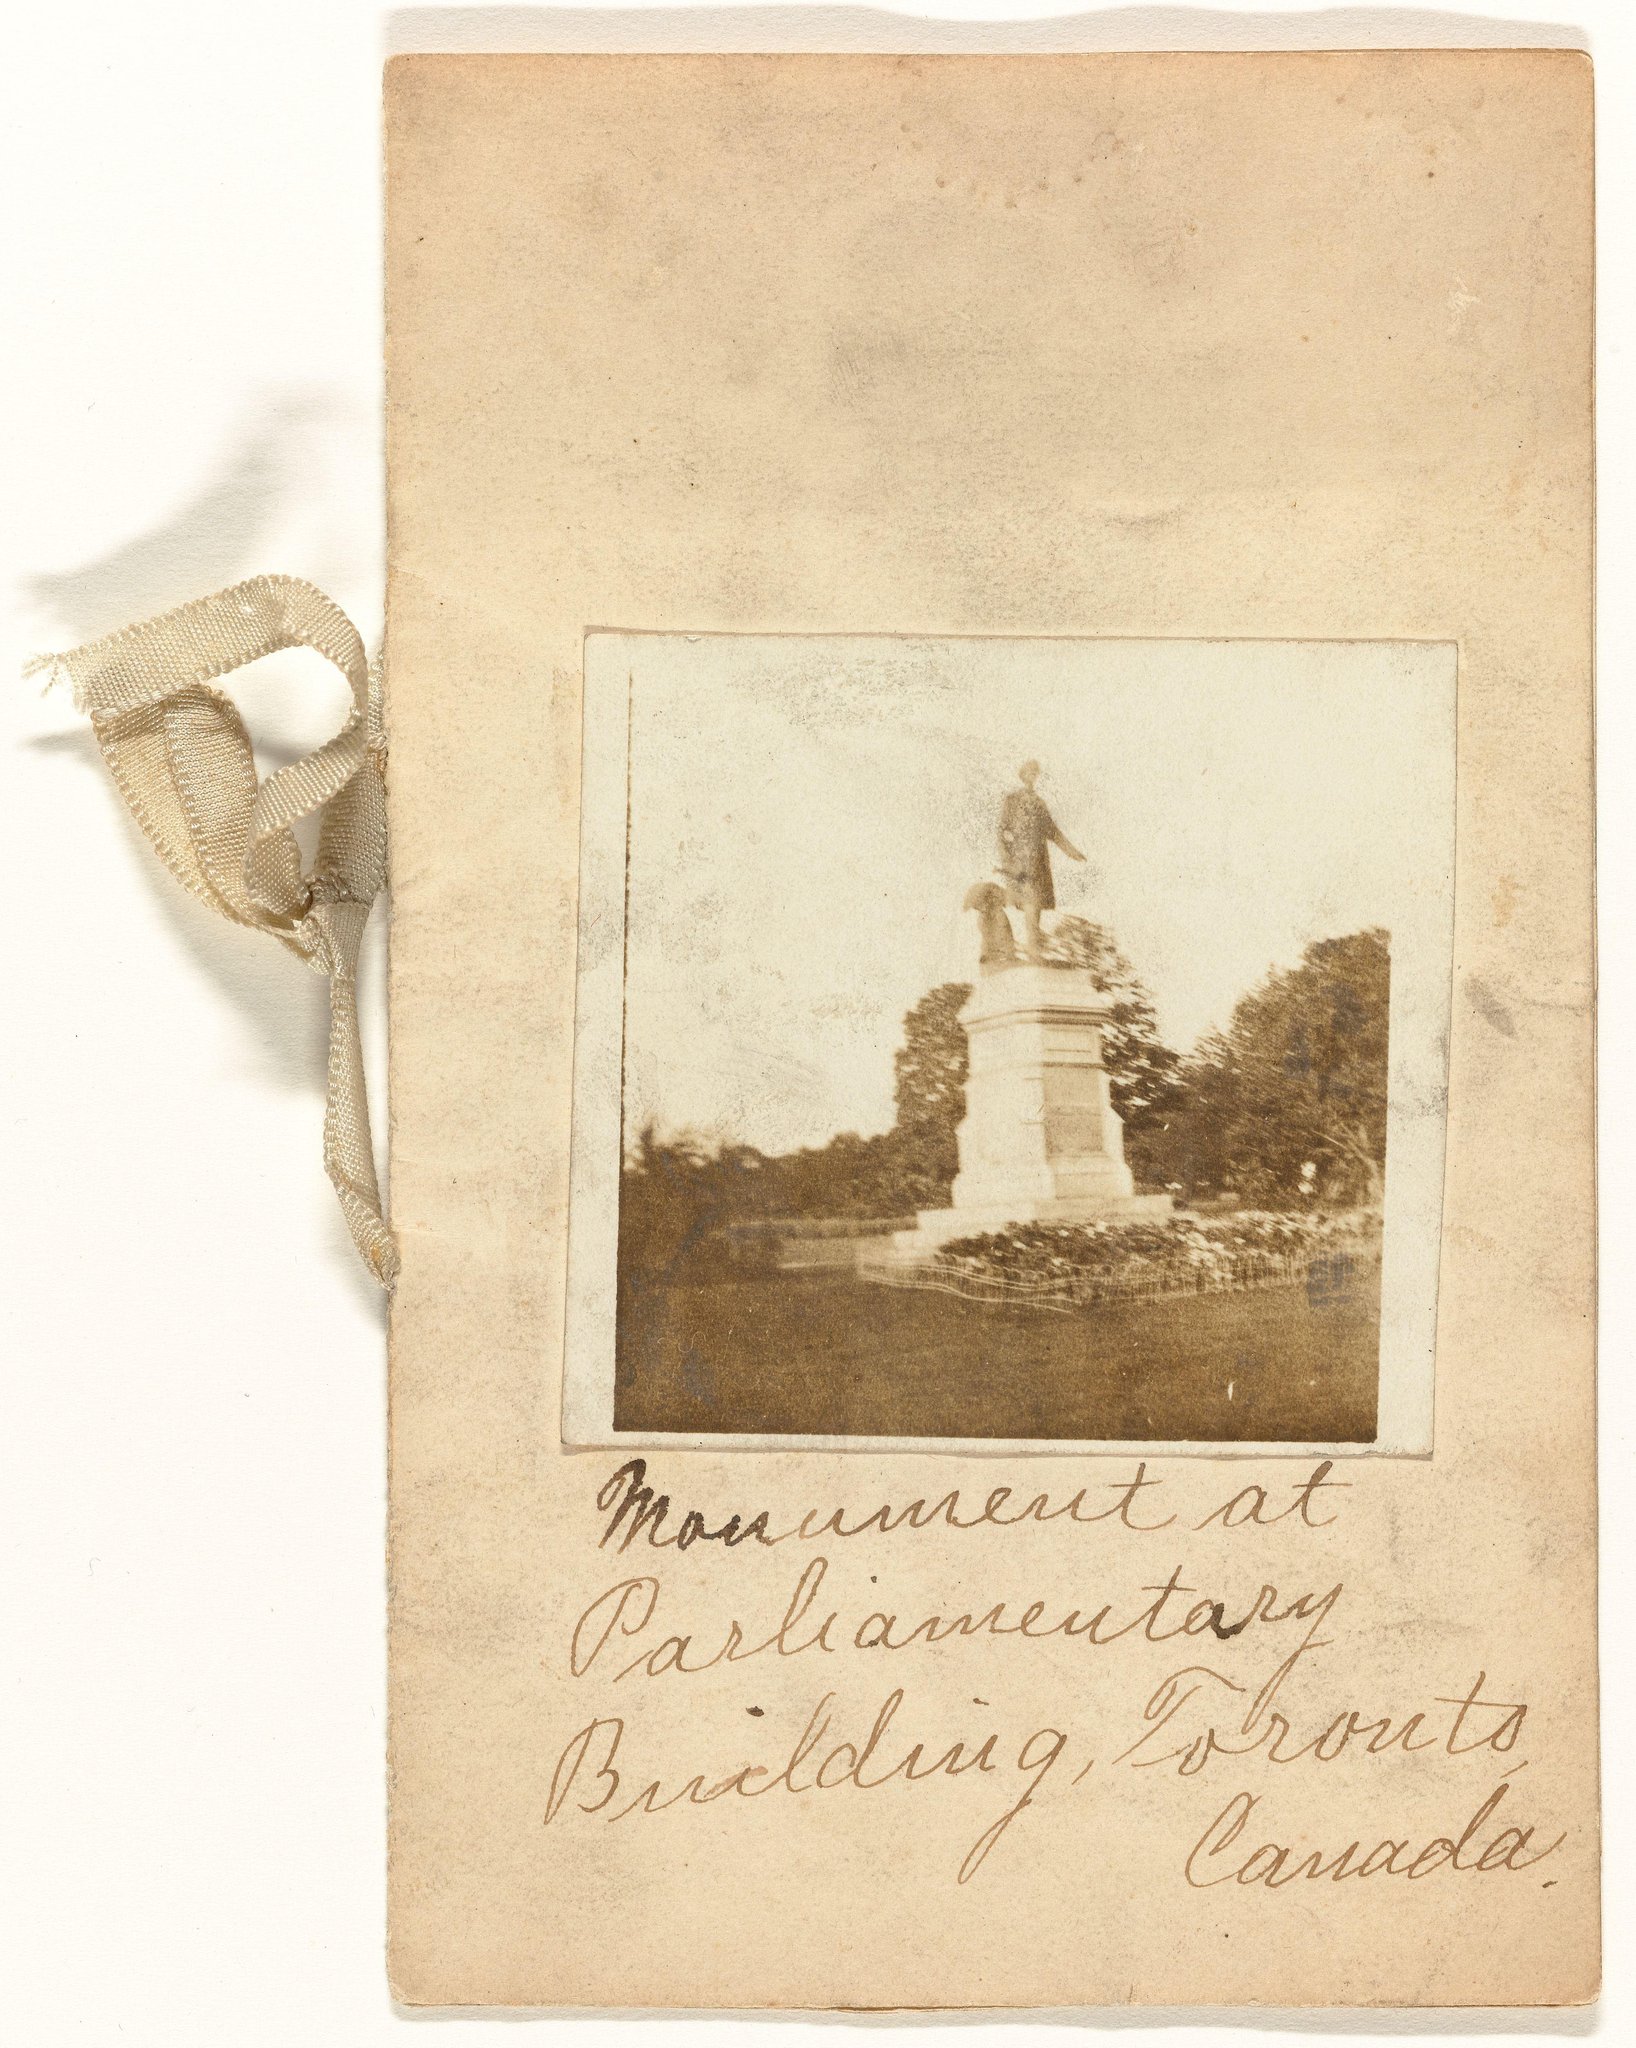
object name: photograph album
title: Ingebonden katern met vijf foto's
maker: Anonymous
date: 1890-1910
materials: paper, ribbon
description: Klein fotoalbum met vijf foto's en een lintje door de vouw.